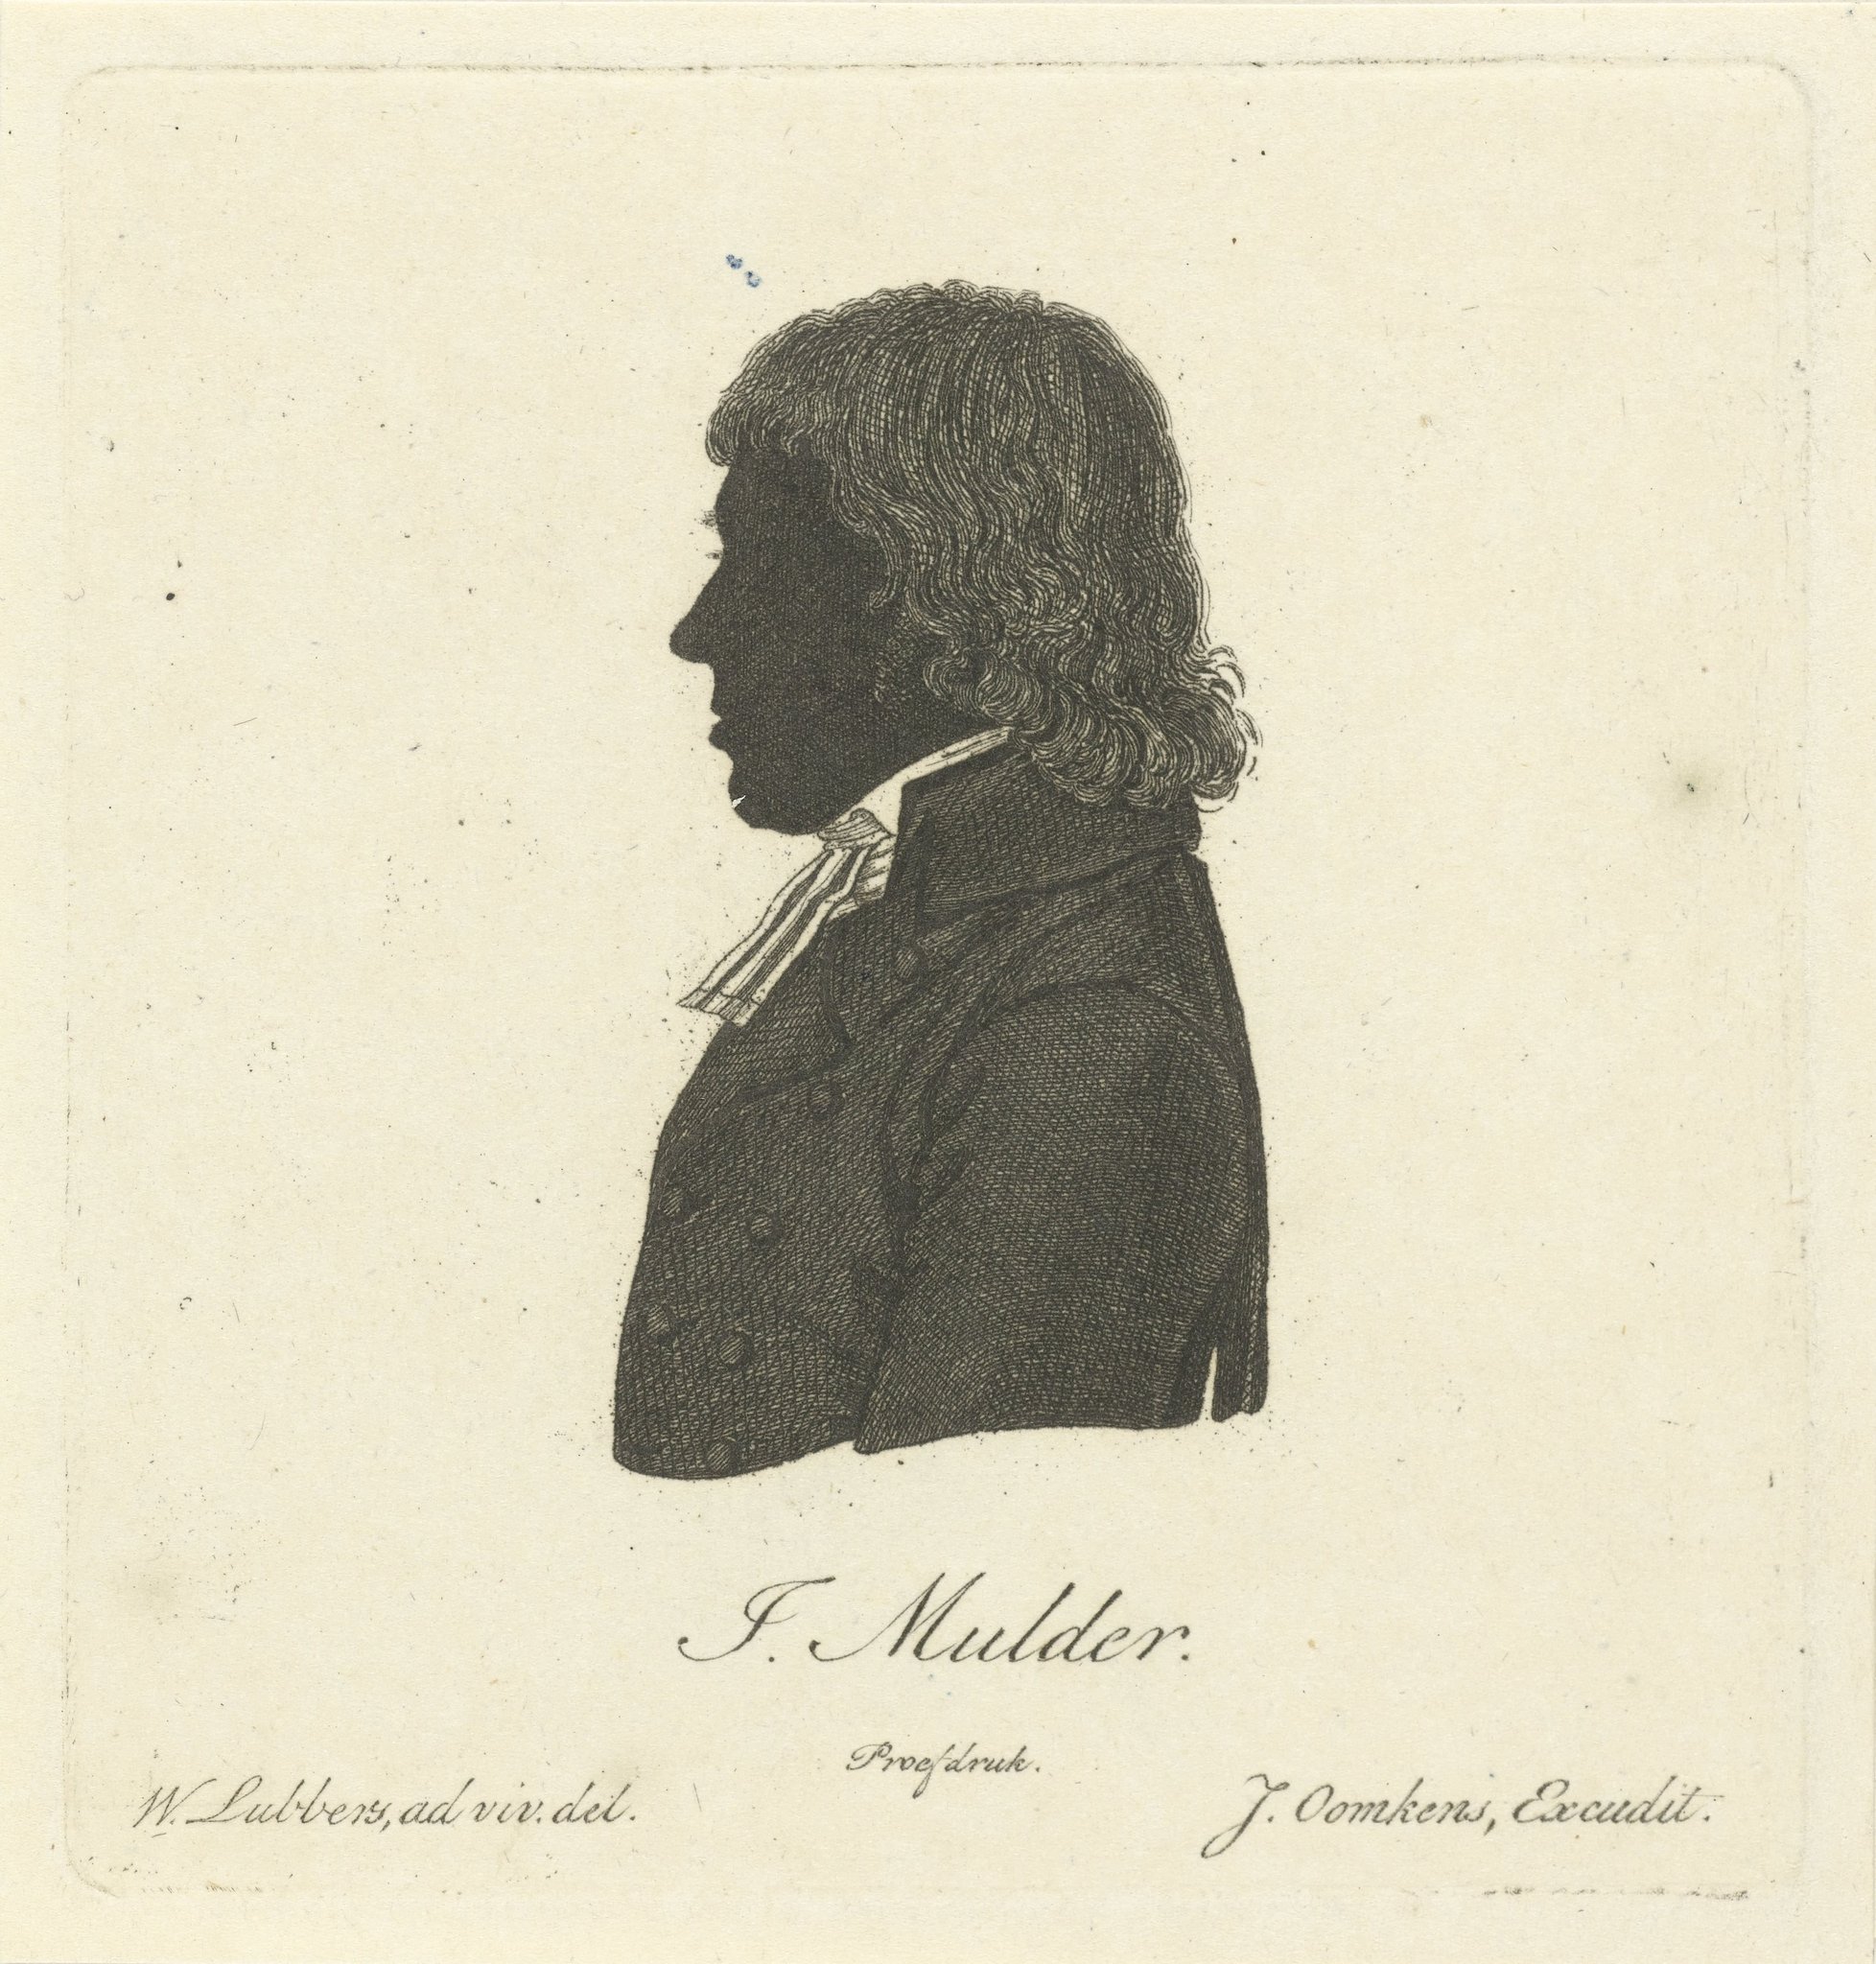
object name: print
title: Silhouetportret van Johannes Mulder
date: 1808-1844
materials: paper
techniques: etching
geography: groningen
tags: veendam, johannes mulder (1775-1832)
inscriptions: collector's mark: Lugt 2228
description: Silhouetportret van Johannes Mulder, buste naar links.